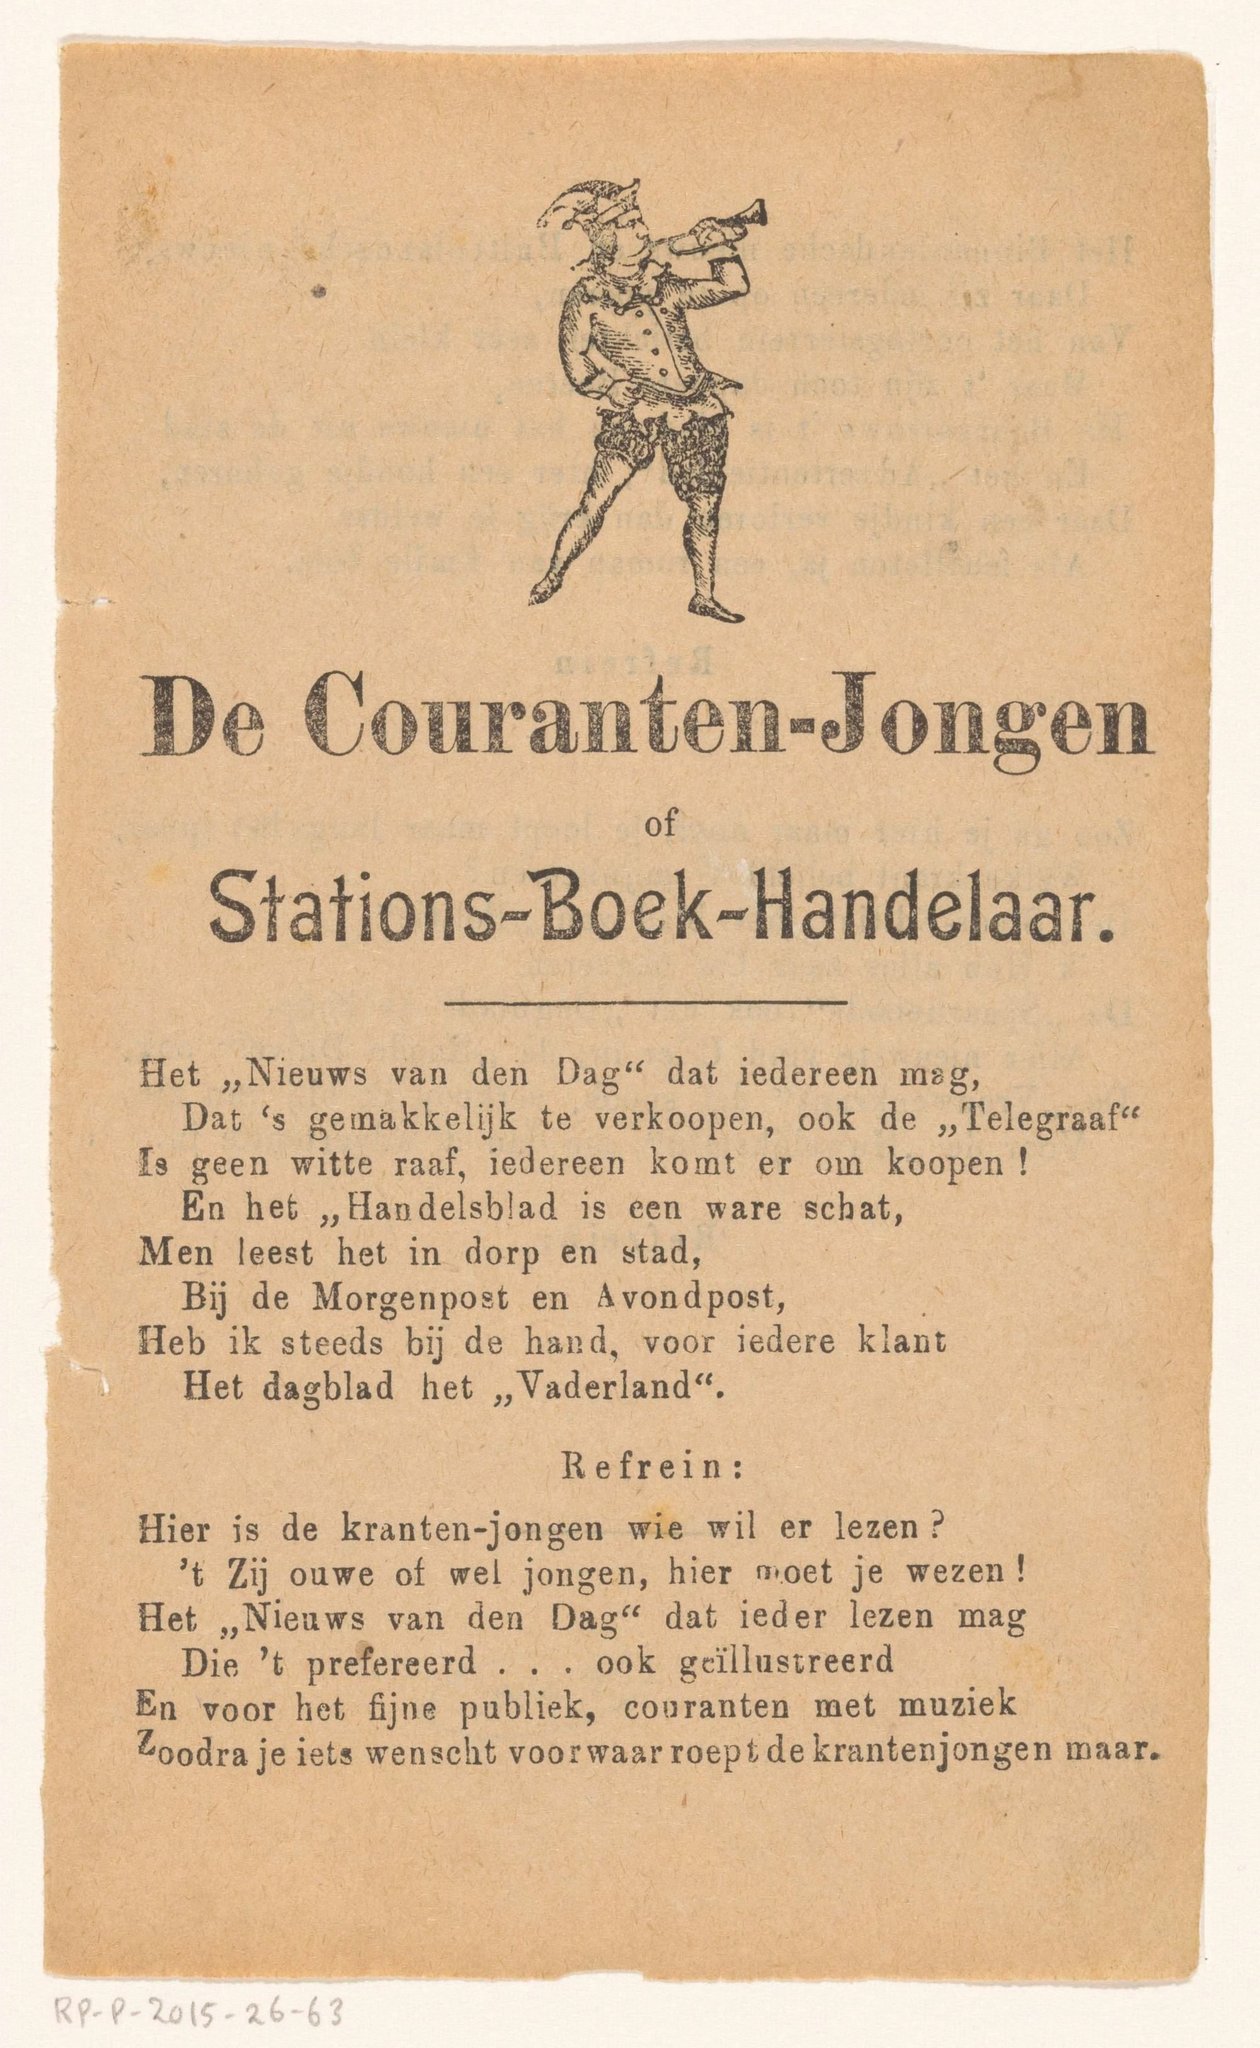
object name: book illustration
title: Nar die op een trompet blaast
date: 1900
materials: paper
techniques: letterpress printing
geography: amsterdam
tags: buffoon (in general) (german: 'schalksnarr')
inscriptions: collector's mark: Lugt 2228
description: Afkomstig uit: Long Tom. Komische Coupletten. De Couranten-Jongen, 't Is 'n Familiekwaal en De Transvaalsche Boer. Amsterdam: E.P.A. van de Geer, s.d.